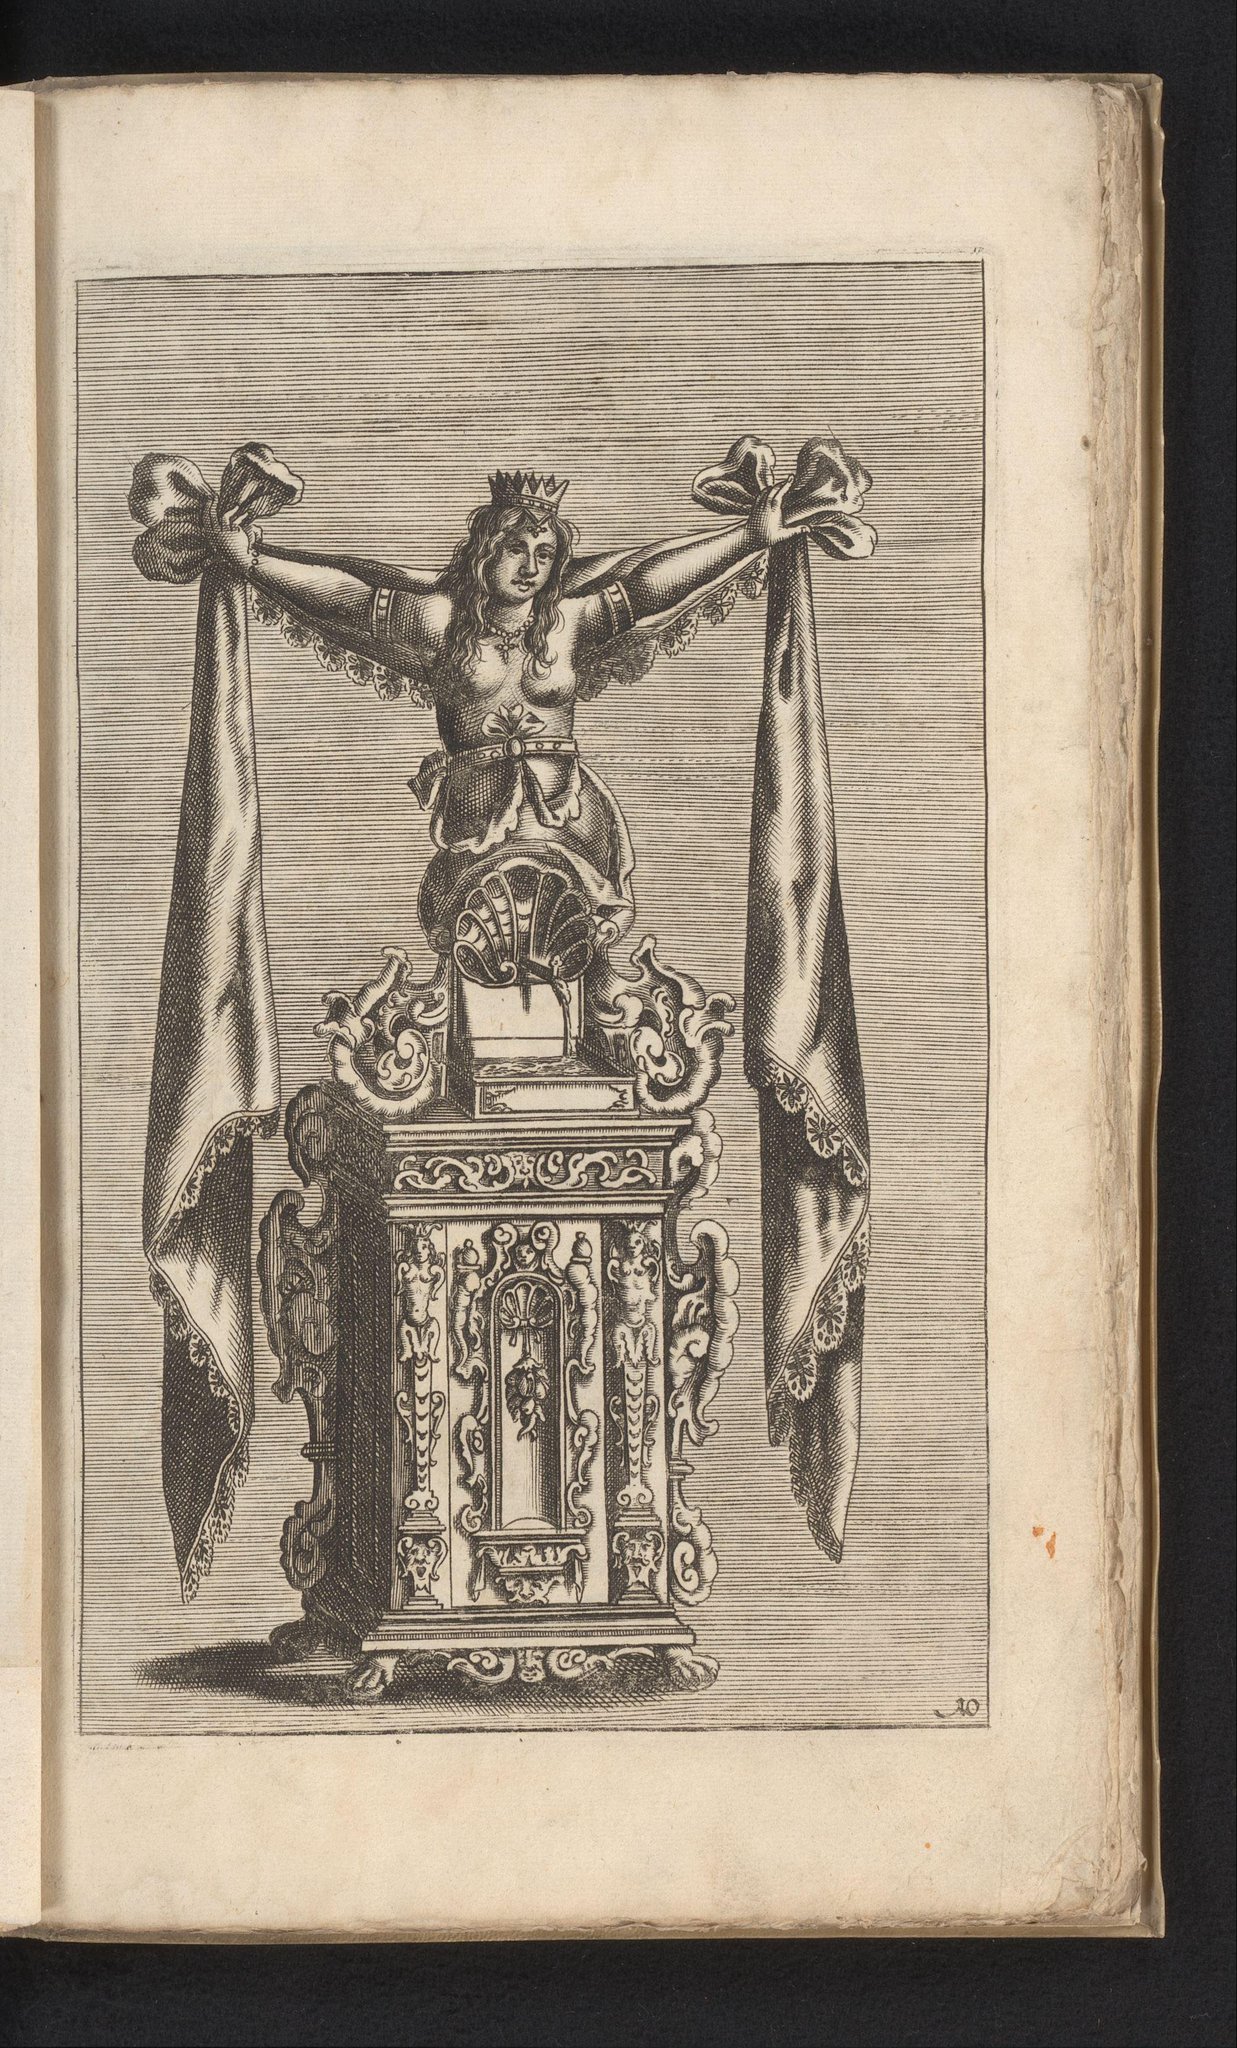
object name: ornament print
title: Neues Zierathen Buch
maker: Anonymous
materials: paper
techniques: engraving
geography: wemding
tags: auricular ornament, lobe style ~ ornament, jug and basin; wash-basin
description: Deze prent maakt deel uit van een album.